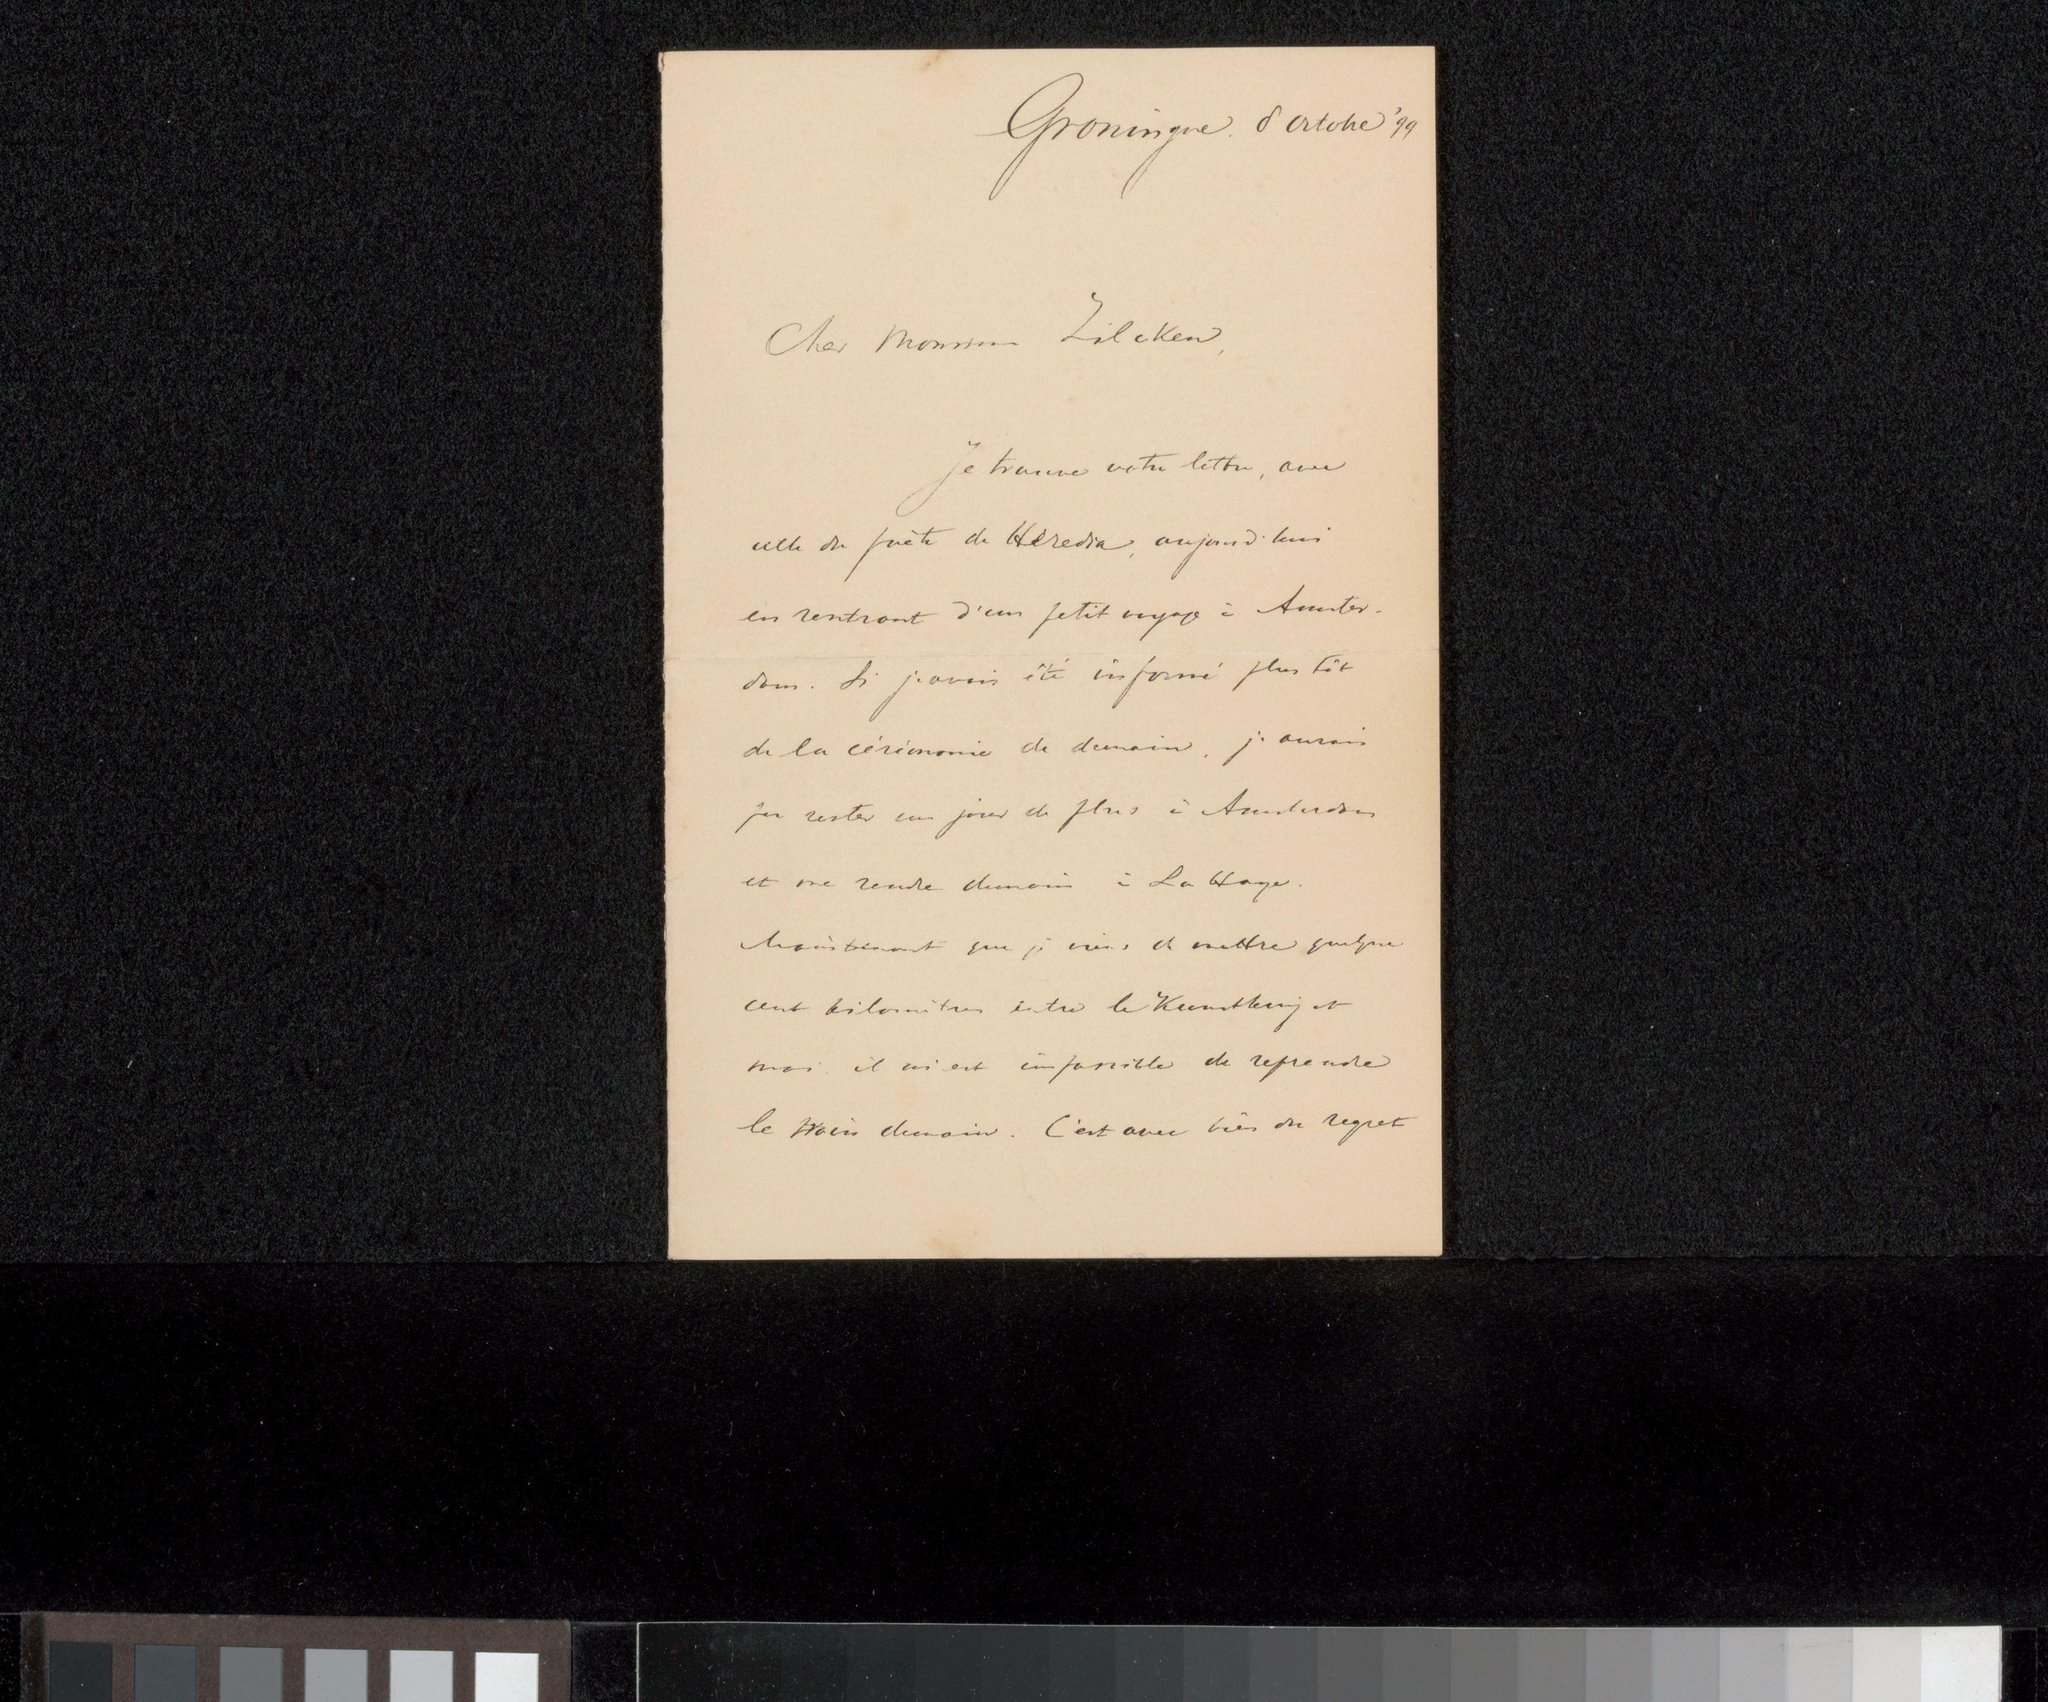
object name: letter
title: Brief aan Philip Zilcken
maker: antonius gerardus van hamel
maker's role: hoogleraar, theoloog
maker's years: 1842-1907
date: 1899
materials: ink, paper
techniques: pen, writing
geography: groningen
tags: paris, print maker, auguste rodin, the hague, painter, draughtsman, philip zilcken, temporary exhibition, 'salon', amsterdam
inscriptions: collector's mark: ‘RPK’